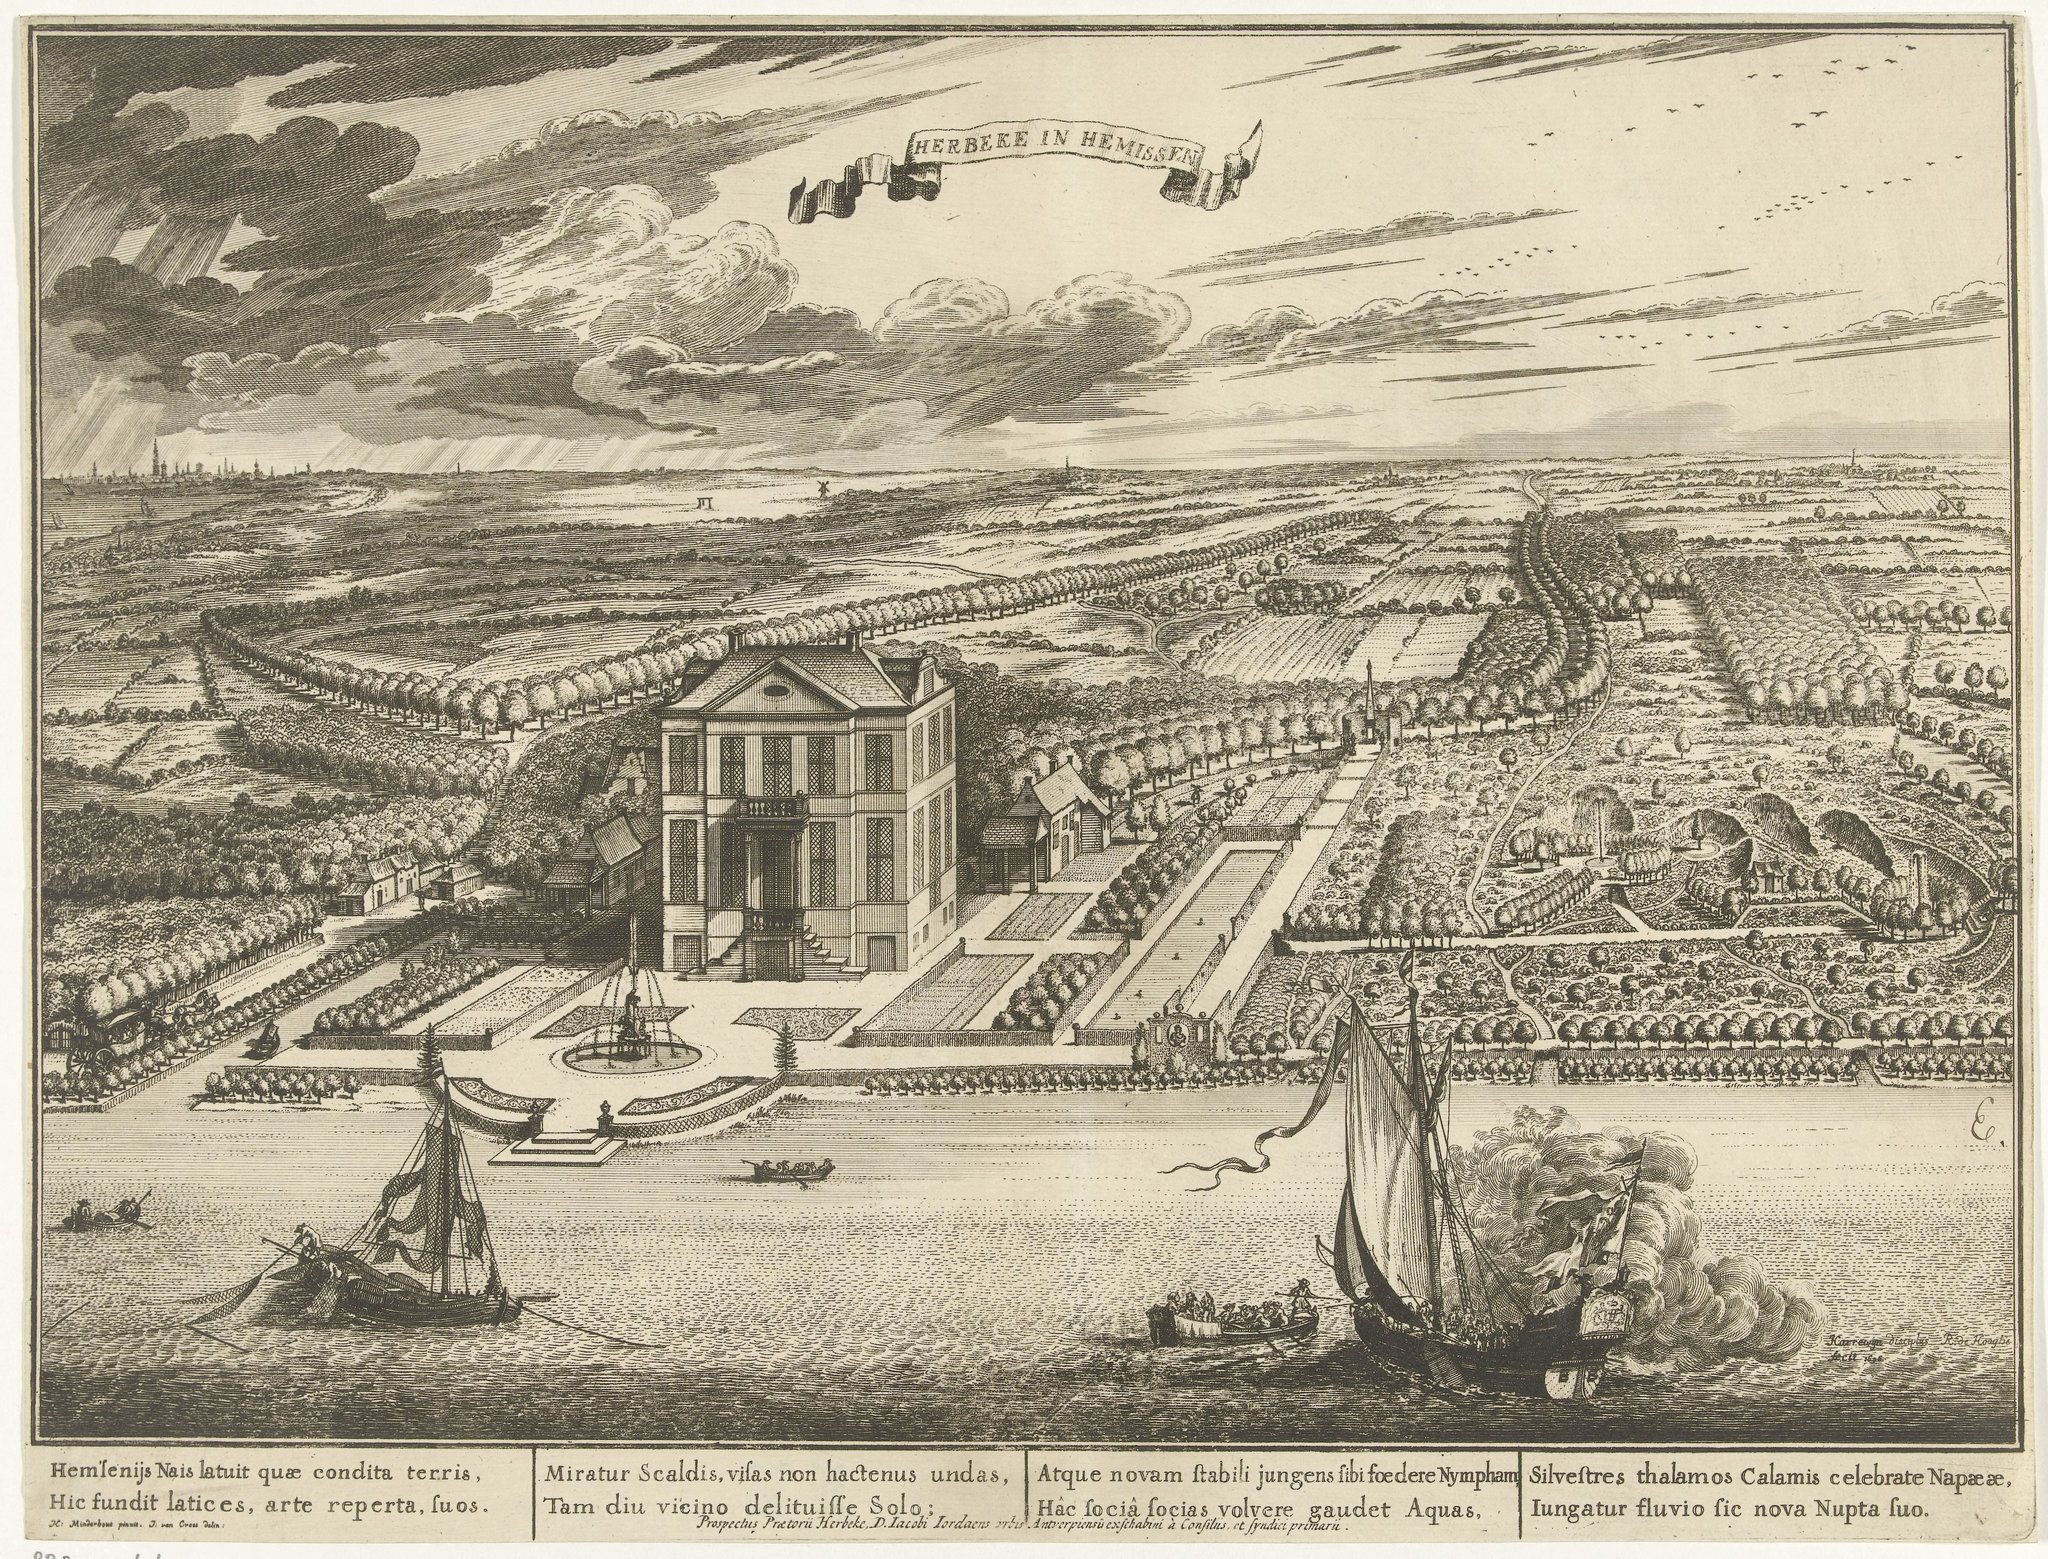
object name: print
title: Herbeke in Hemissen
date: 1696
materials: paper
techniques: engraving, etching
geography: southern netherlands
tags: landscape with tower or castle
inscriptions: collector's mark: Lugt 2228, inscription: ‘E.’, collector's mark: Lugt 1731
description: Gezicht op kasteel Herbeke in Hemiksen in vogelperspectief. Bovenaan de titel op een lint, onderaan vier kolommen met elk twee regels in het Latijn.